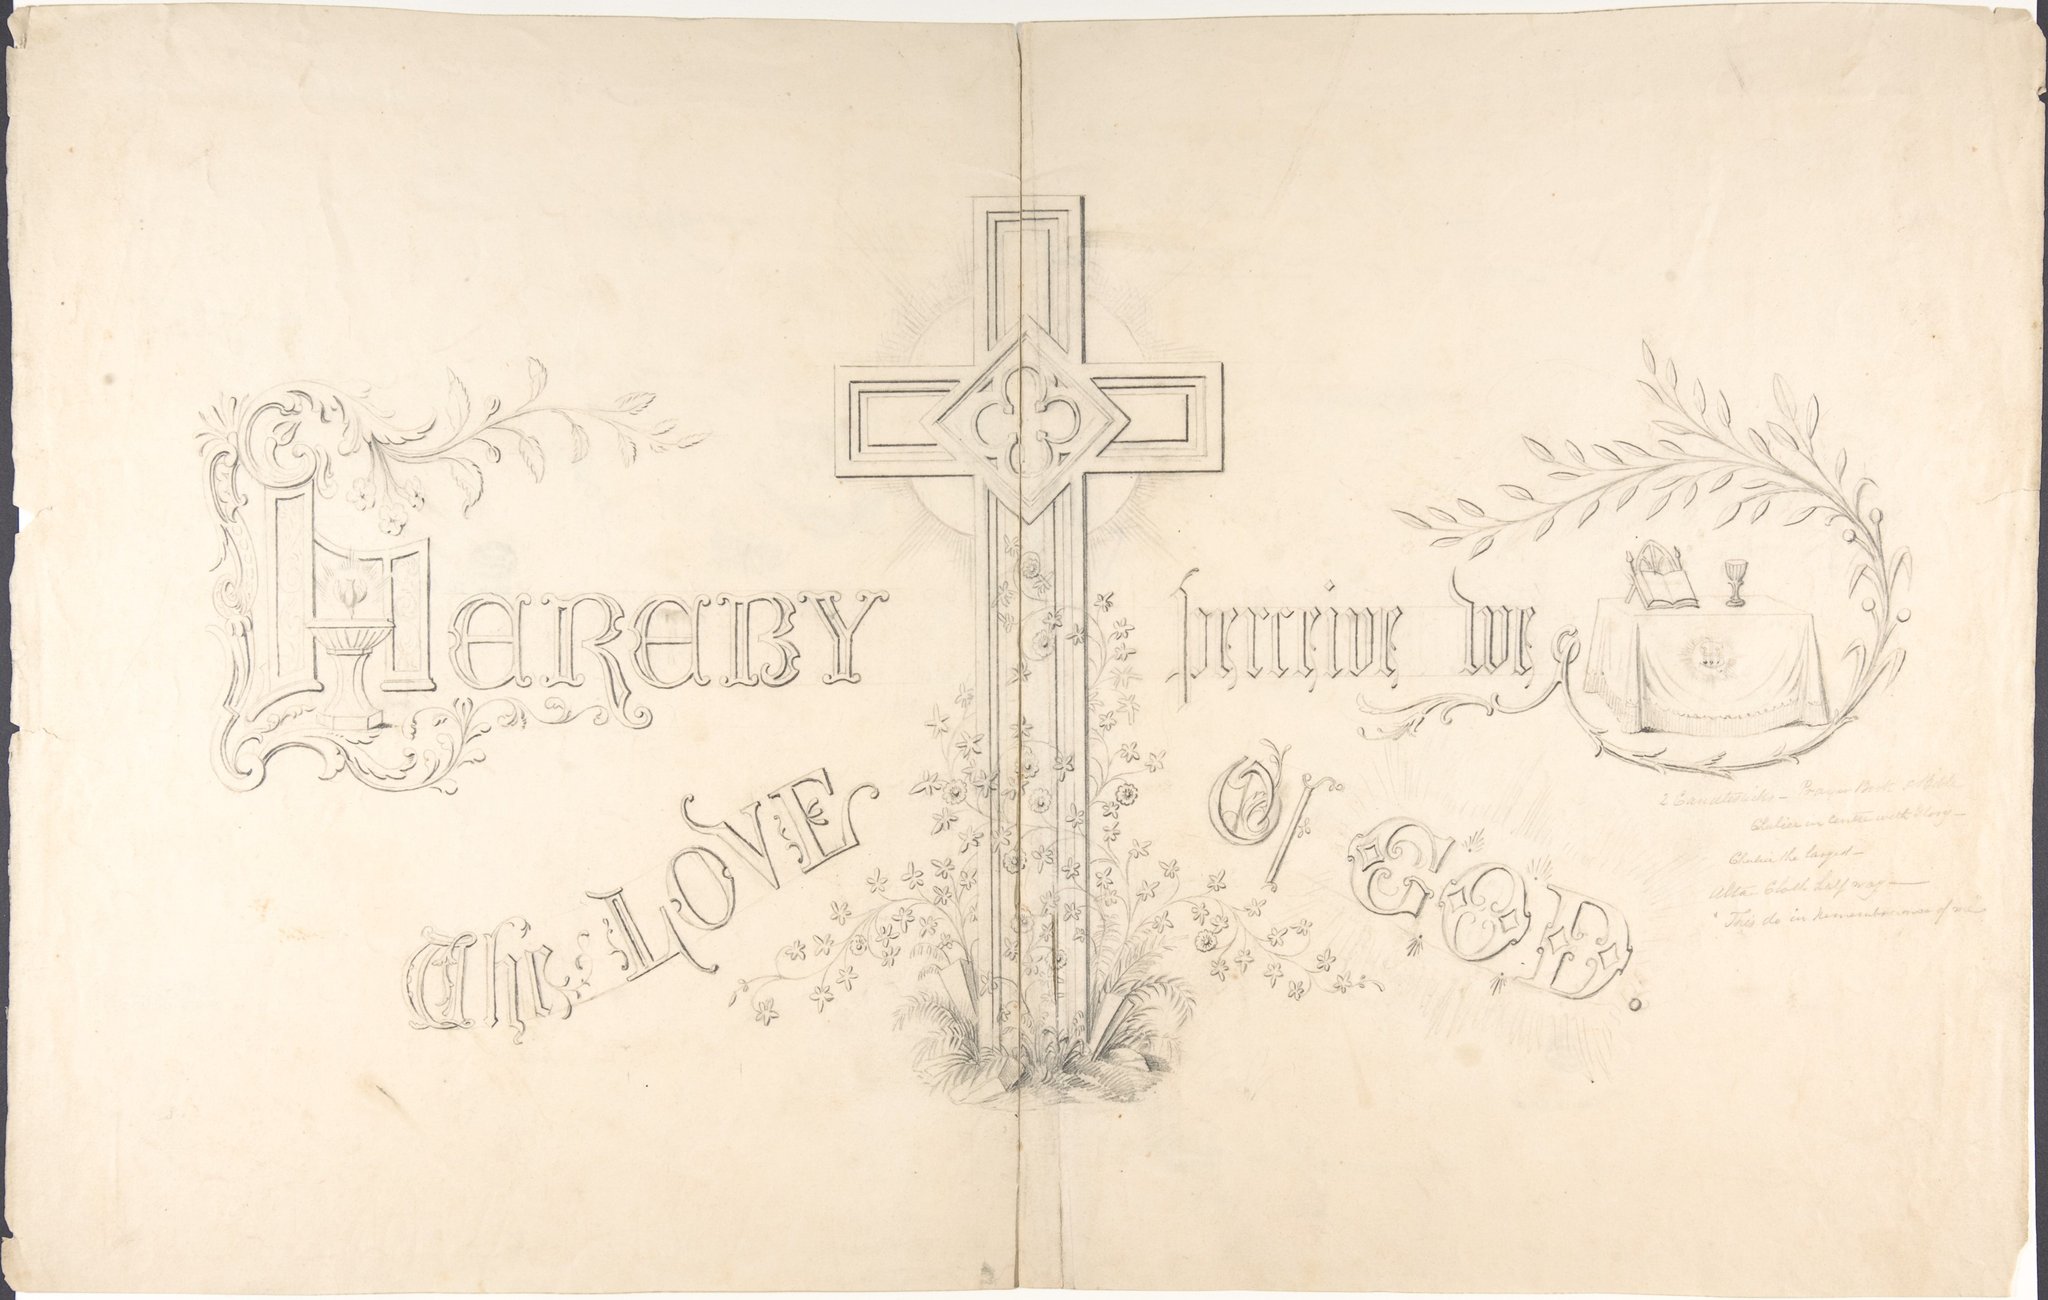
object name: drawing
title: Design for Religious Motto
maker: robert william hume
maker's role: artist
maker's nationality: british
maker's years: 1816-1904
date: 1830-1900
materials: graphite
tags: leaves,cross